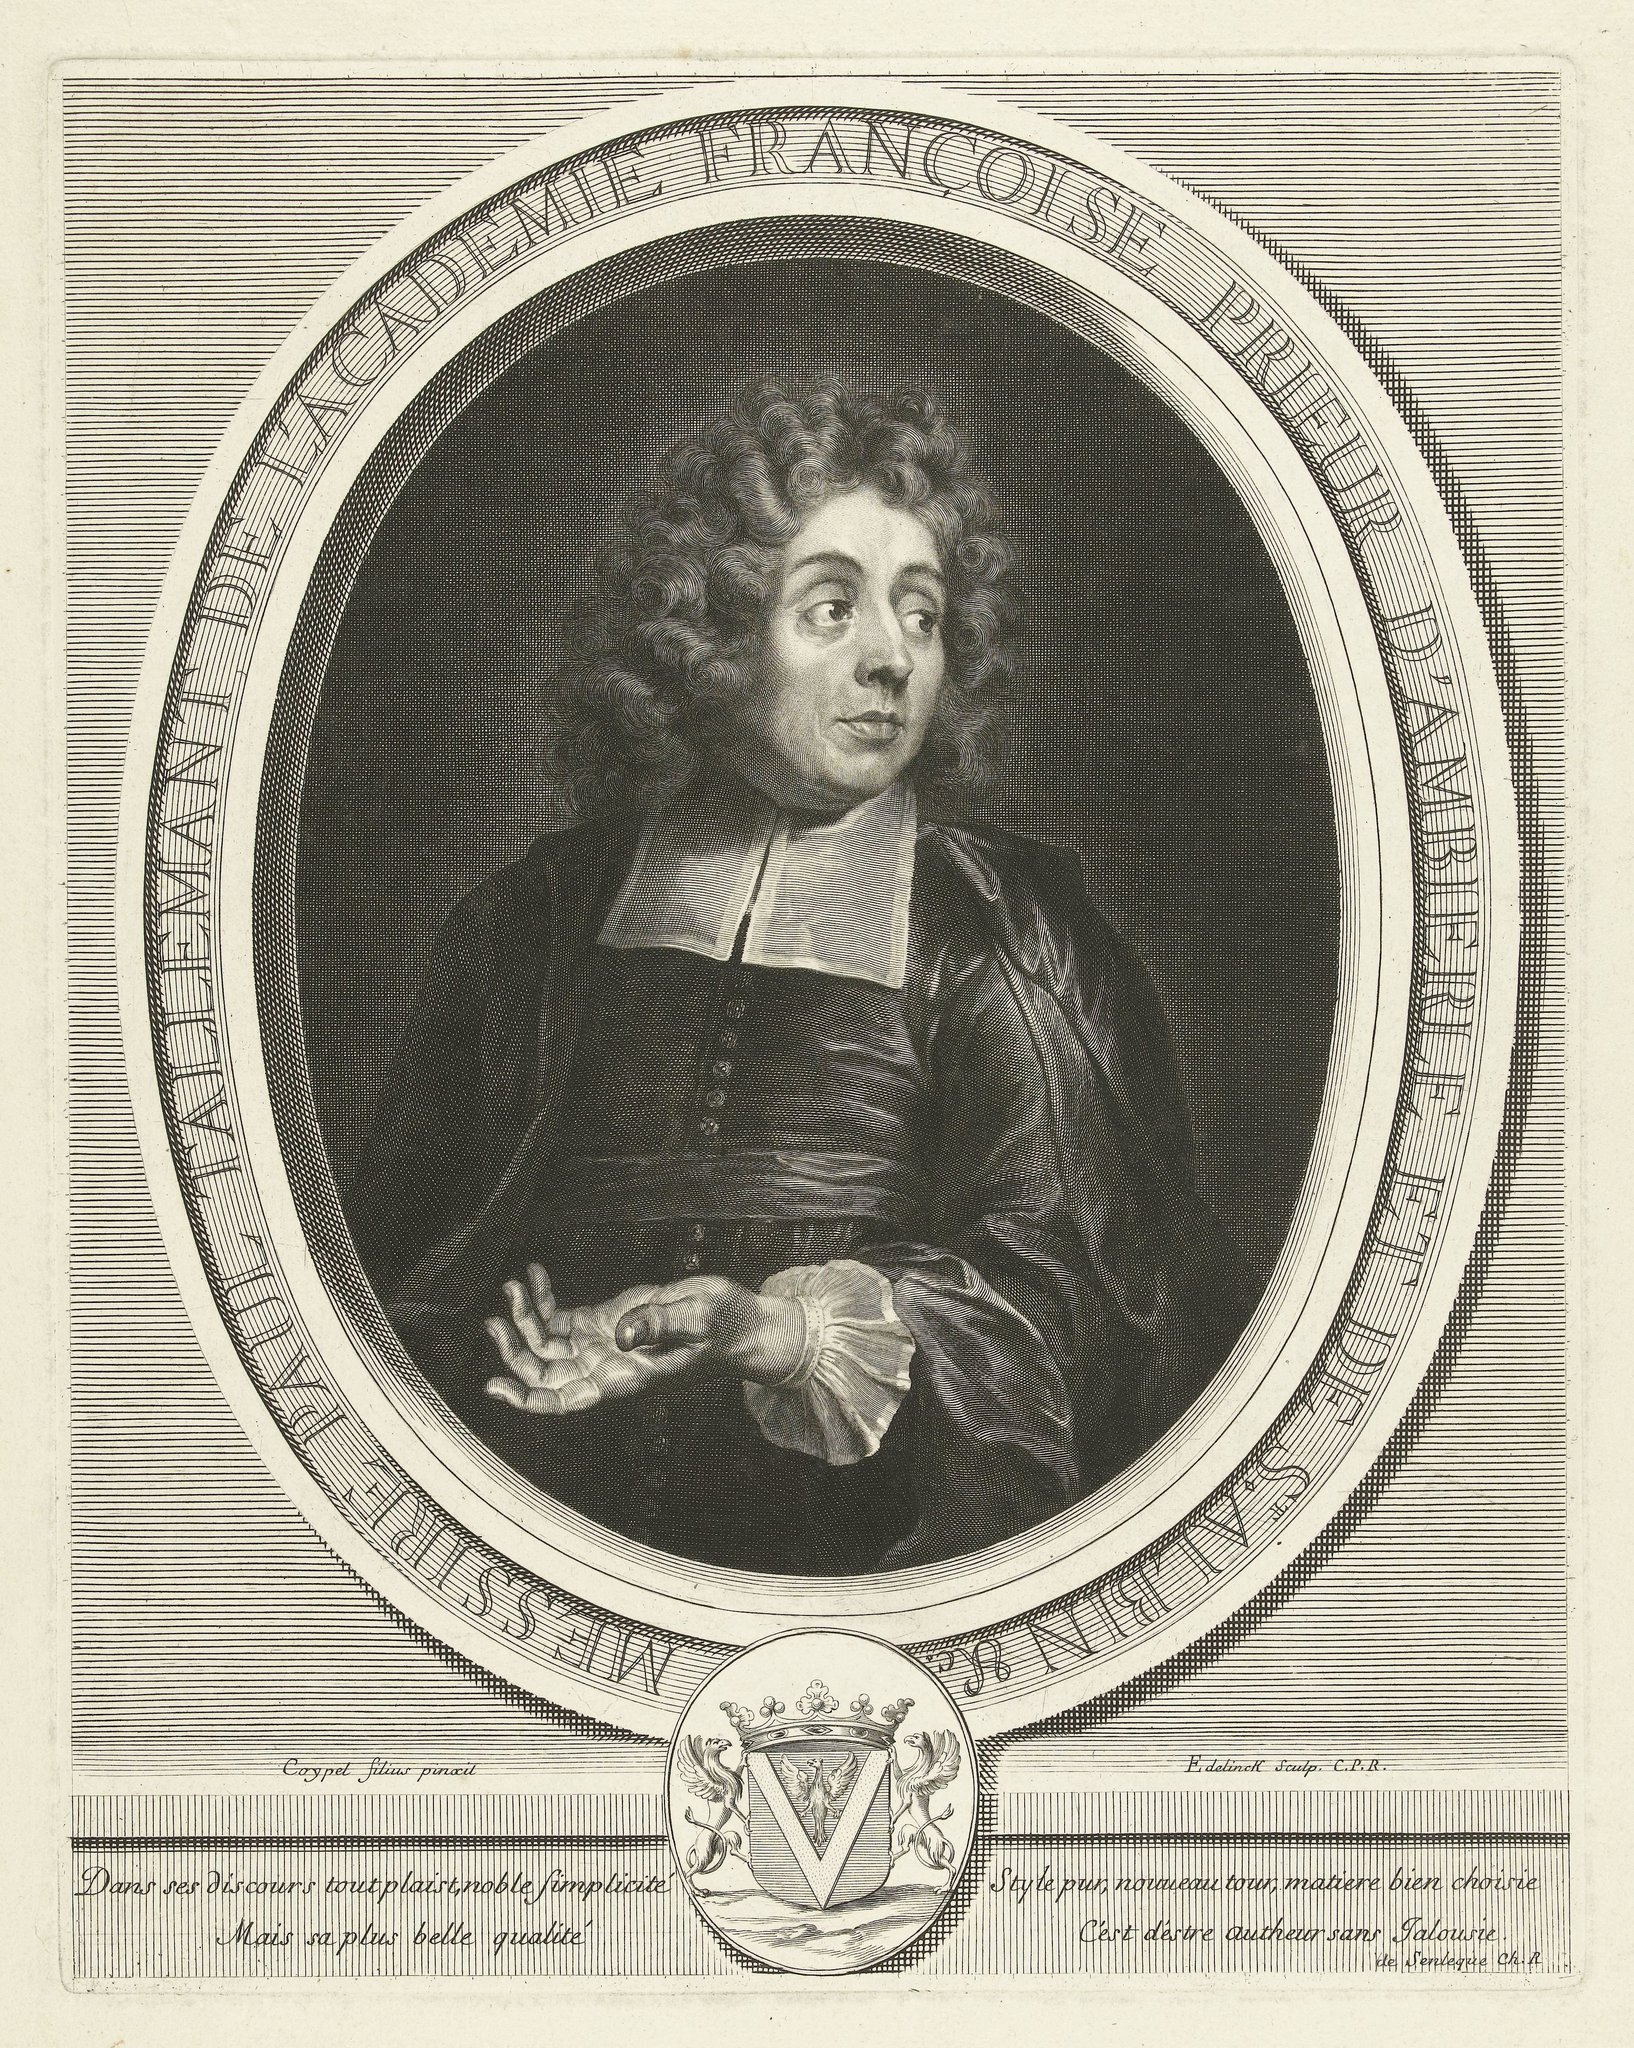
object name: print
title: Portret van Paul Tallemant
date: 1666-1707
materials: paper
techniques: engraving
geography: france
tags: paul tallemant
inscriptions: collector's mark: Lugt 2228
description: Portret van de Franse geleerde en prior Paul Tallemant (1642-1712), afgebeeld in ovale omlijsting met Franse tekst. Onder de lijst een console met een wapen en aan weerszijden een vers van twee regels in Frans.